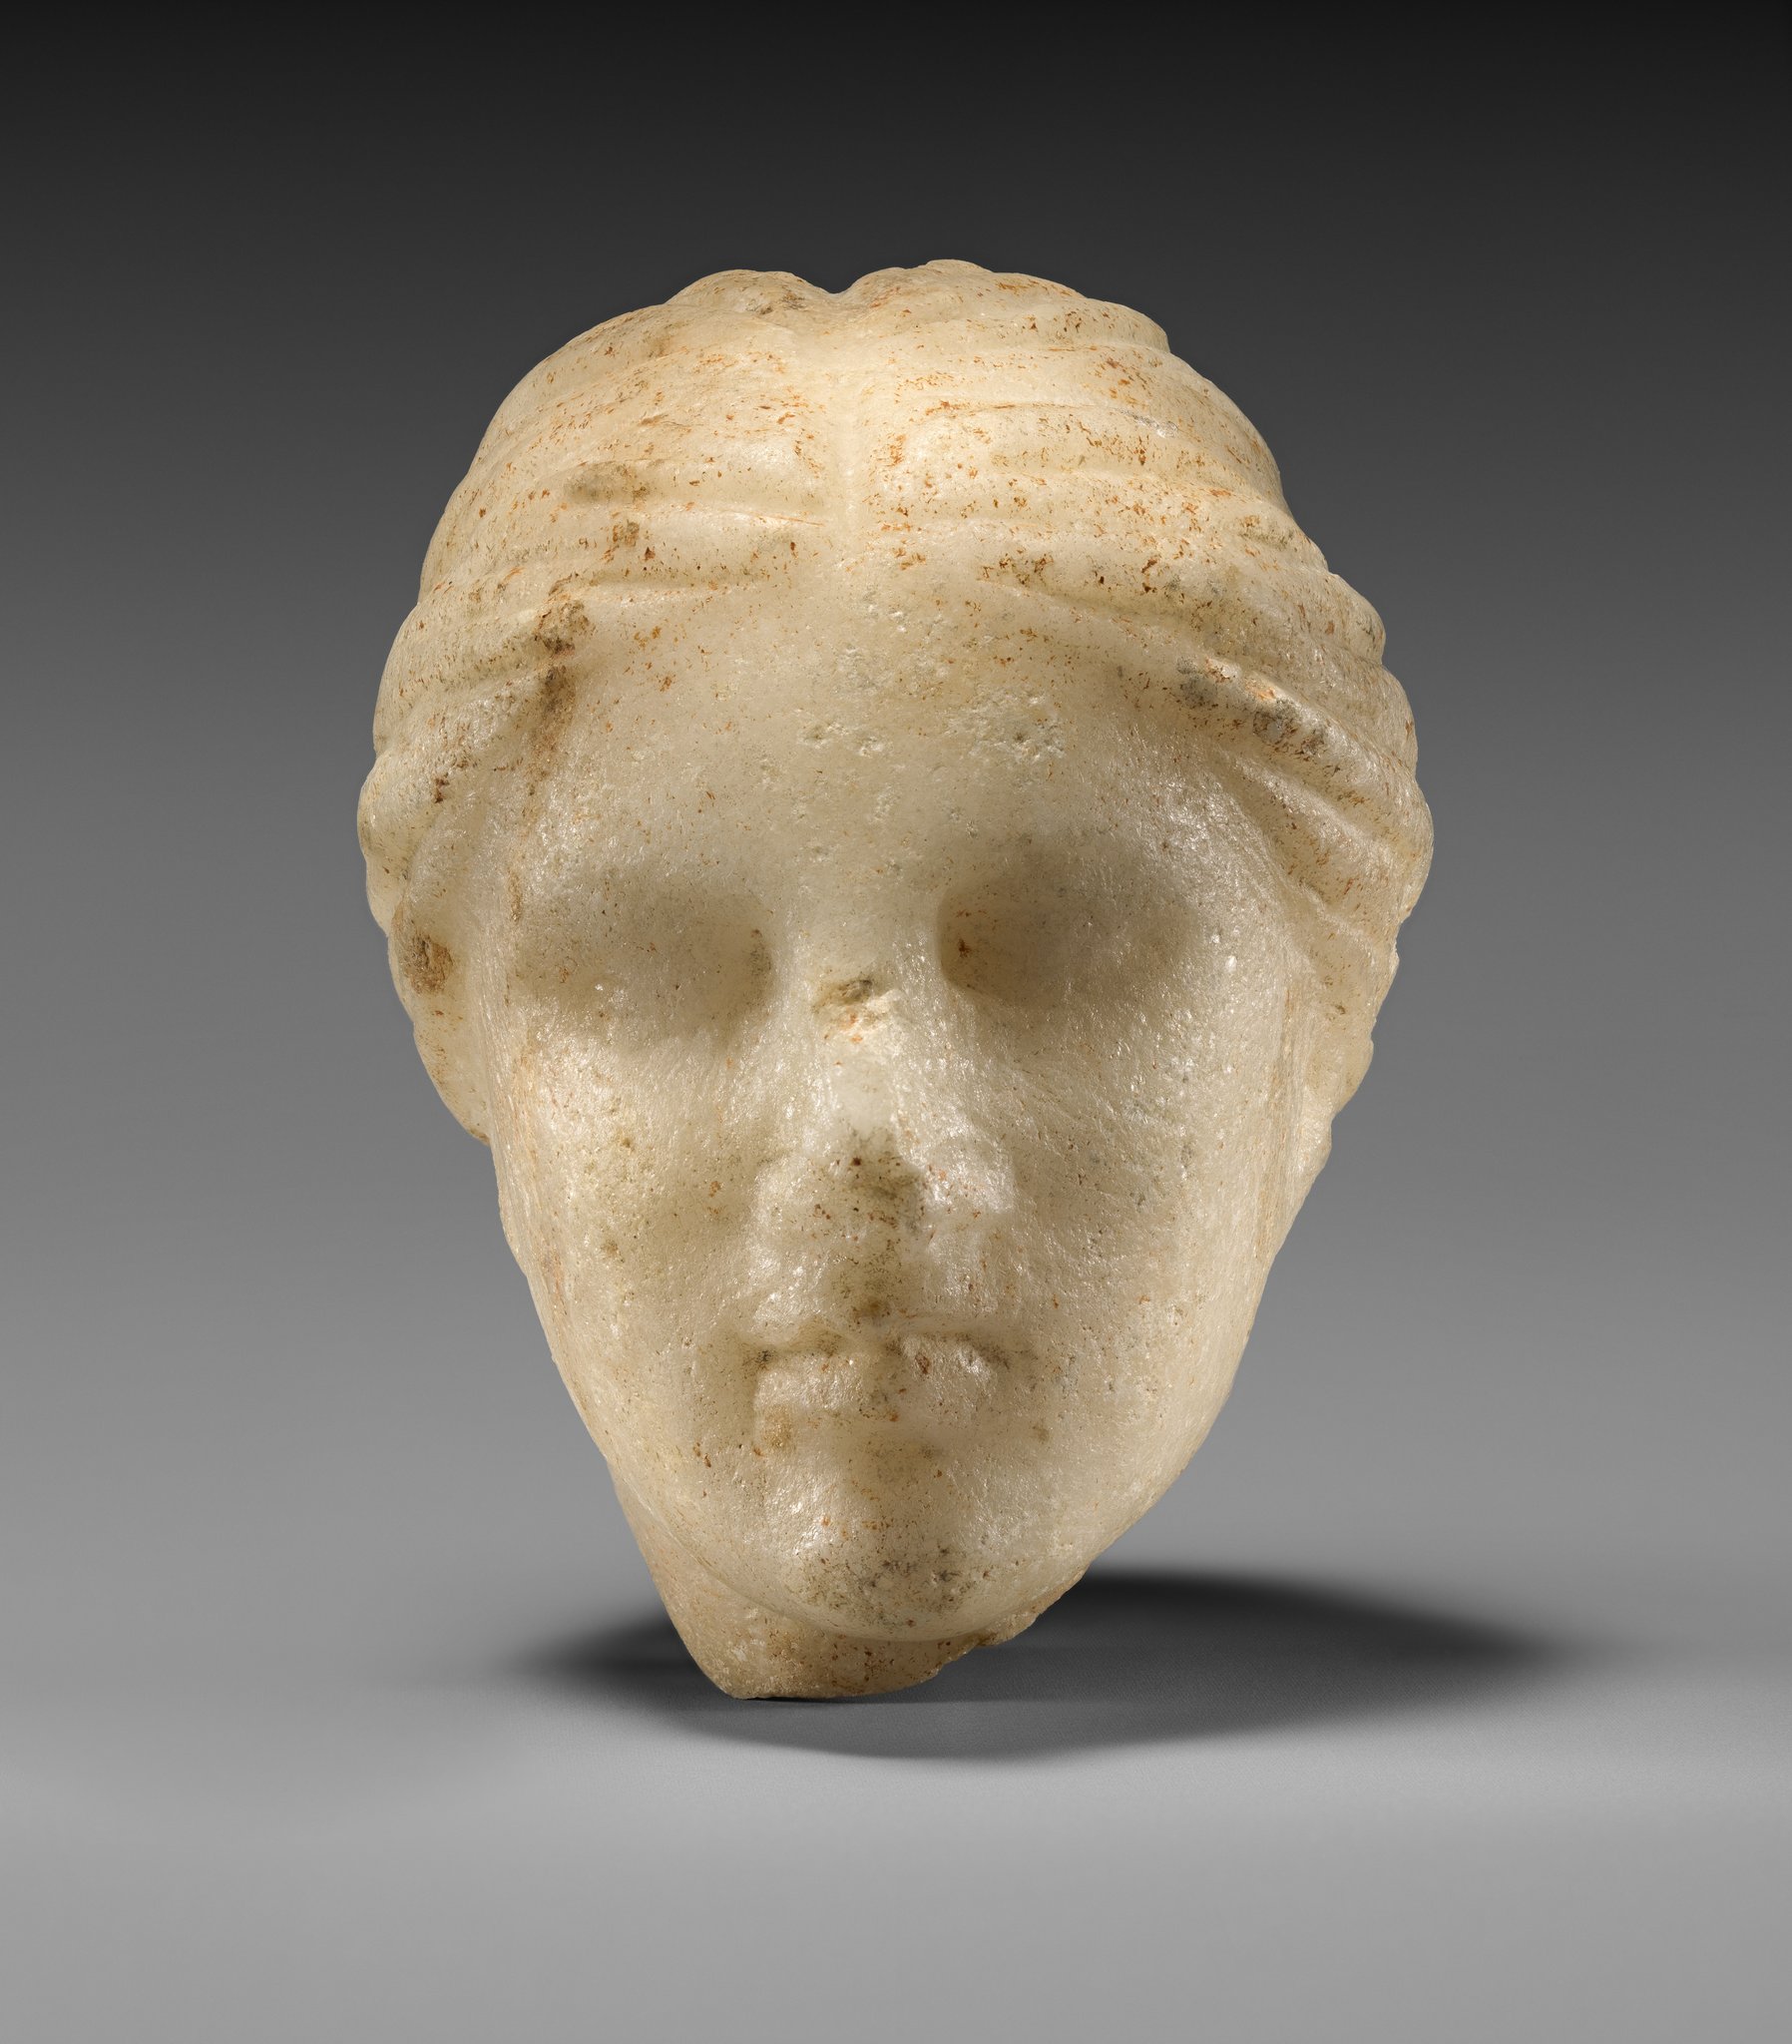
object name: head of aphrodite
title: Marble head of Aphrodite?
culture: greek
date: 200-1 BCE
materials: marble